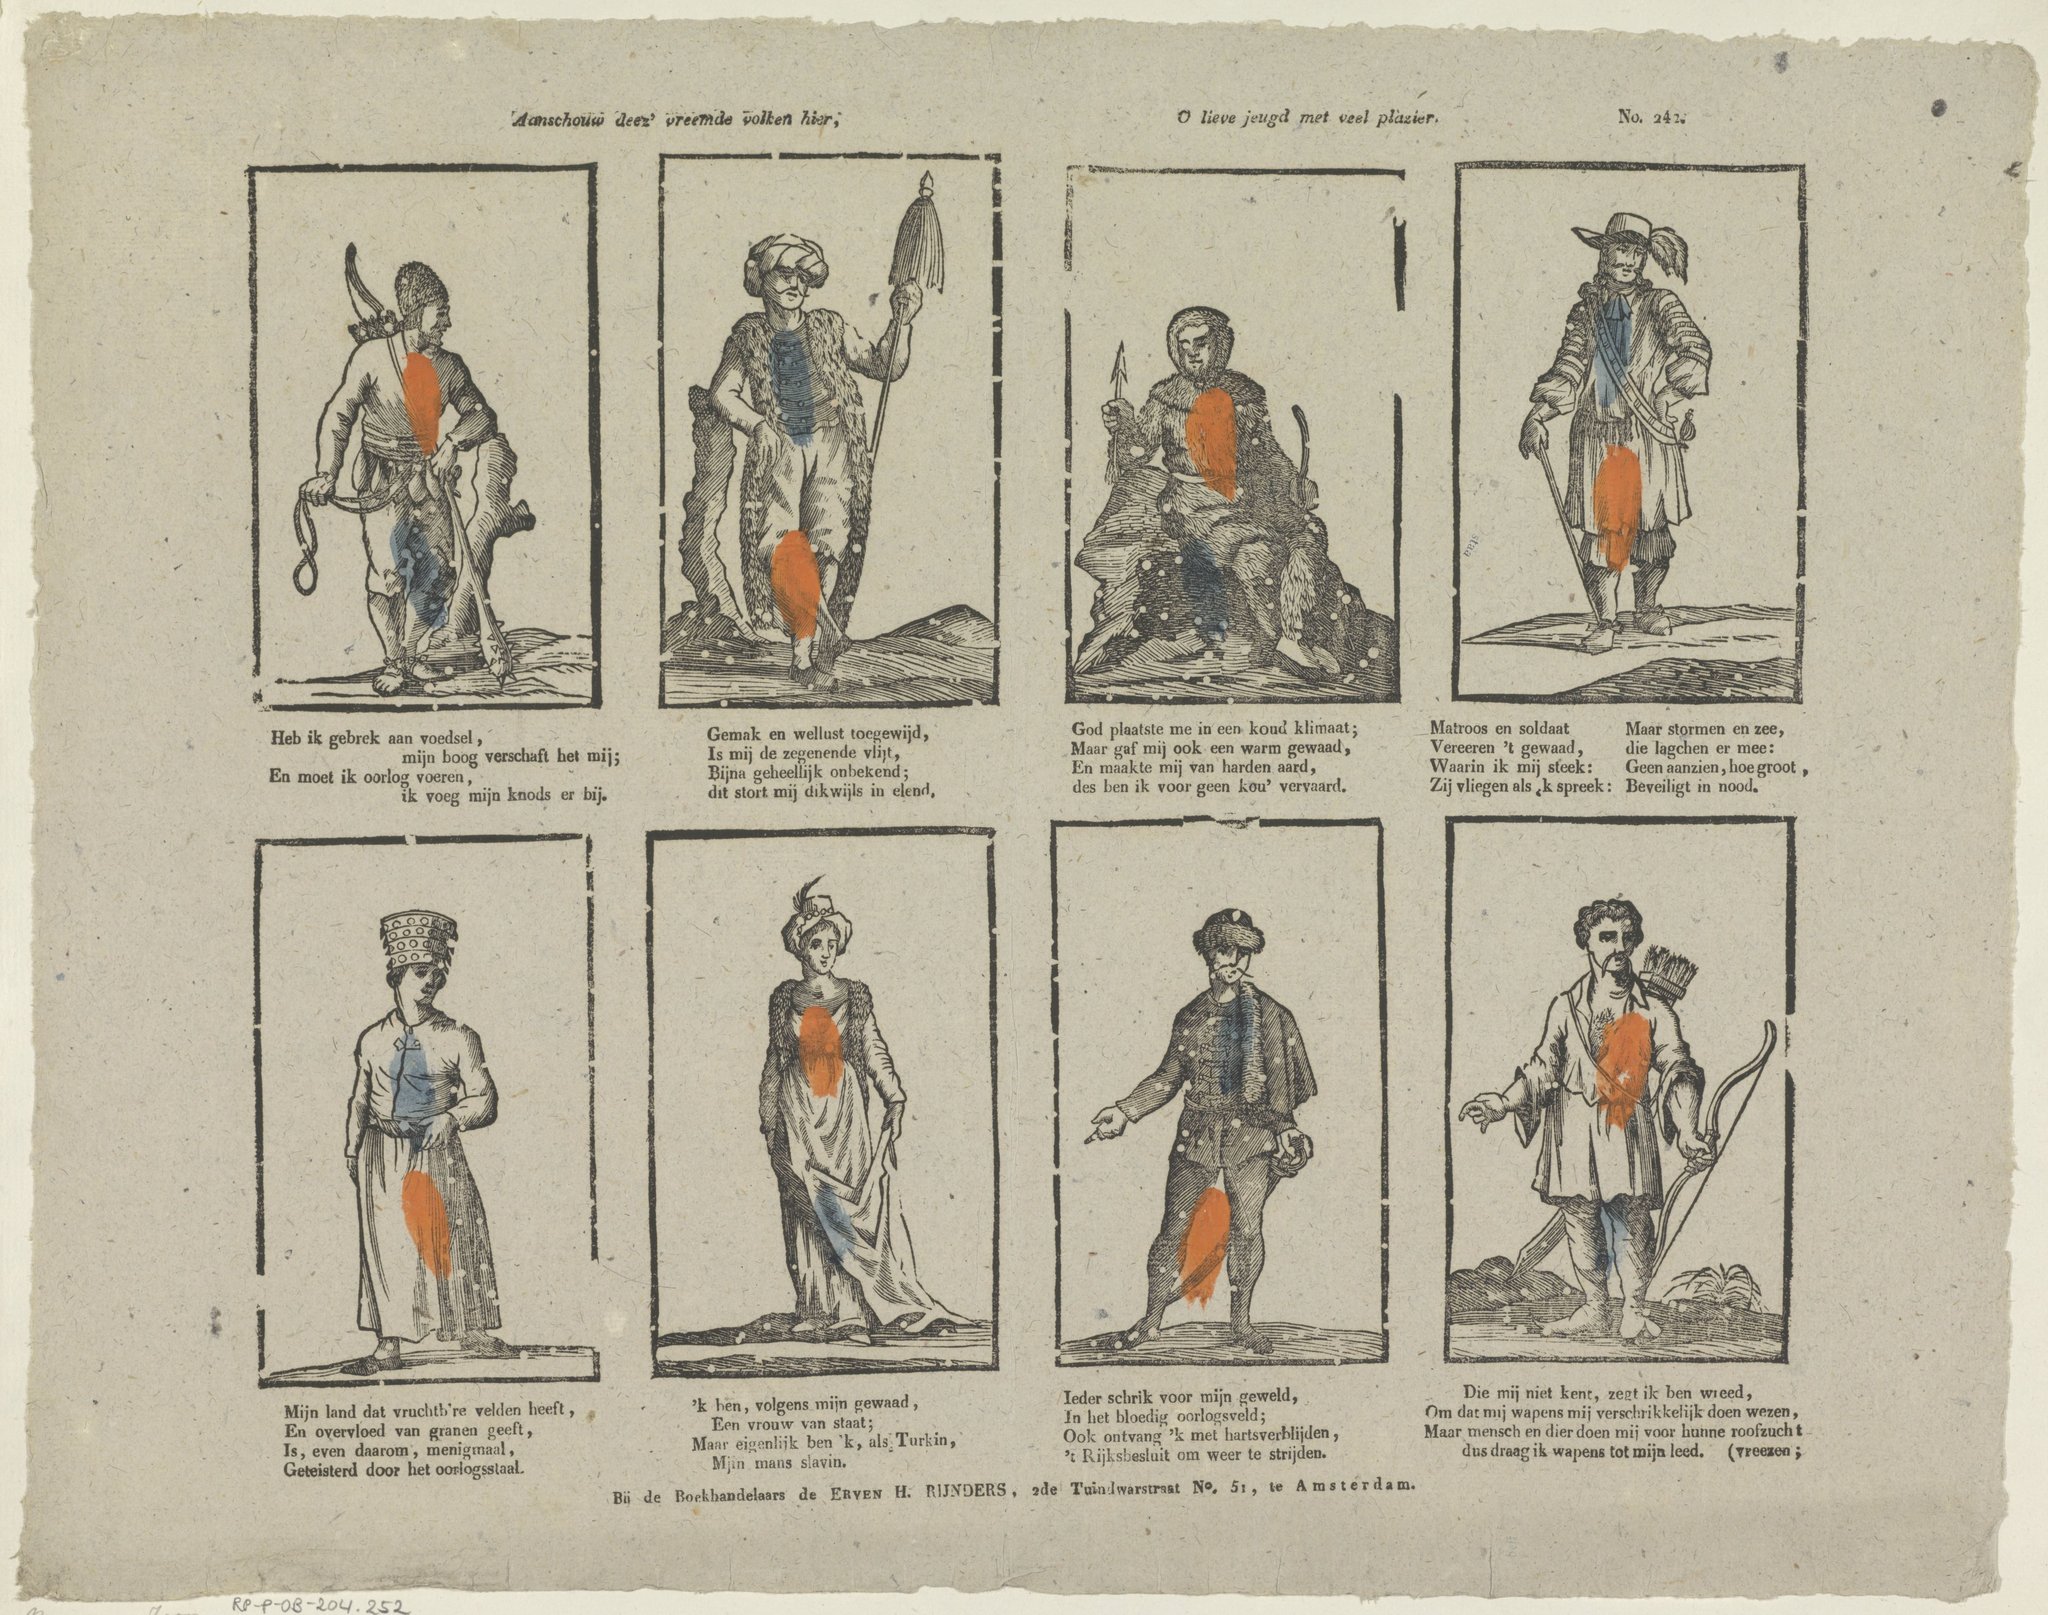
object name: popular print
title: Aanschouw deez' vreemde volken hier, / O lieve jeugd met veel plazier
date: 1806-1854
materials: paper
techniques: colour, letterpress printing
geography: amsterdam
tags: asiatic races and peoples, indigenous peoples of the american arctic regions, asiatic races and peoples: turks, human types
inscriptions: collector's mark: Lugt 2760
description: Blad met 8 voorstellingen van figuren uit verschillende landen. Onder elke afbeelding een vierregelig vers. Genummerd rechtsboven: No. 242.